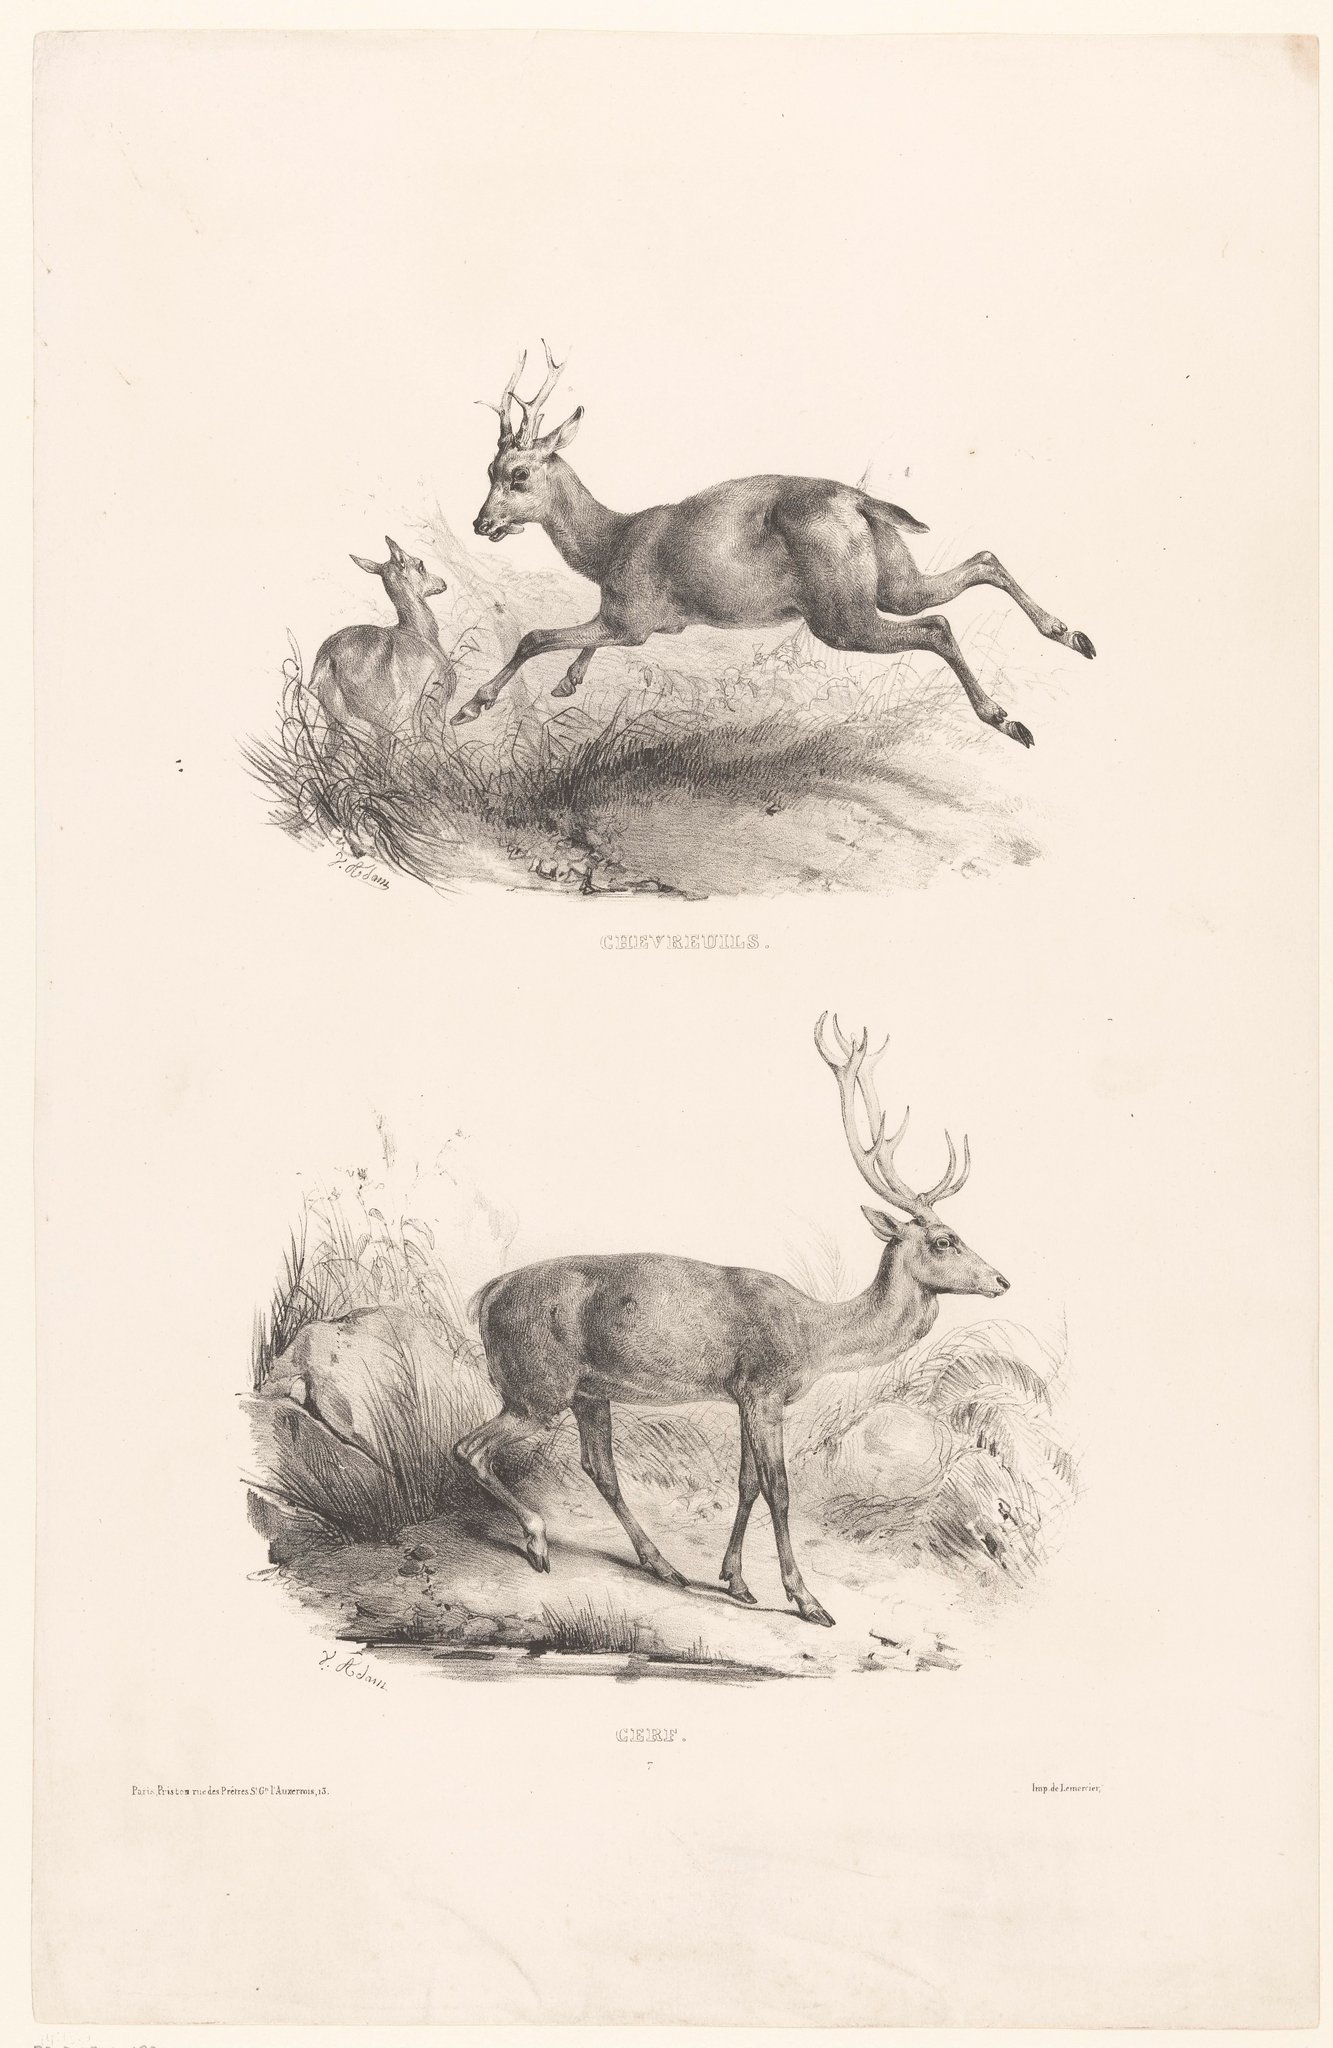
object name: print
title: Chevreuils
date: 1837-1843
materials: paper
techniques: lithograph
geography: paris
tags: hoofed animals: deer, hoofed animals: stag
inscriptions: collector's mark: Lugt 2228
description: Deze prent is uitgegeven als onderdeel van een serie waarvan de titel onbekend is.